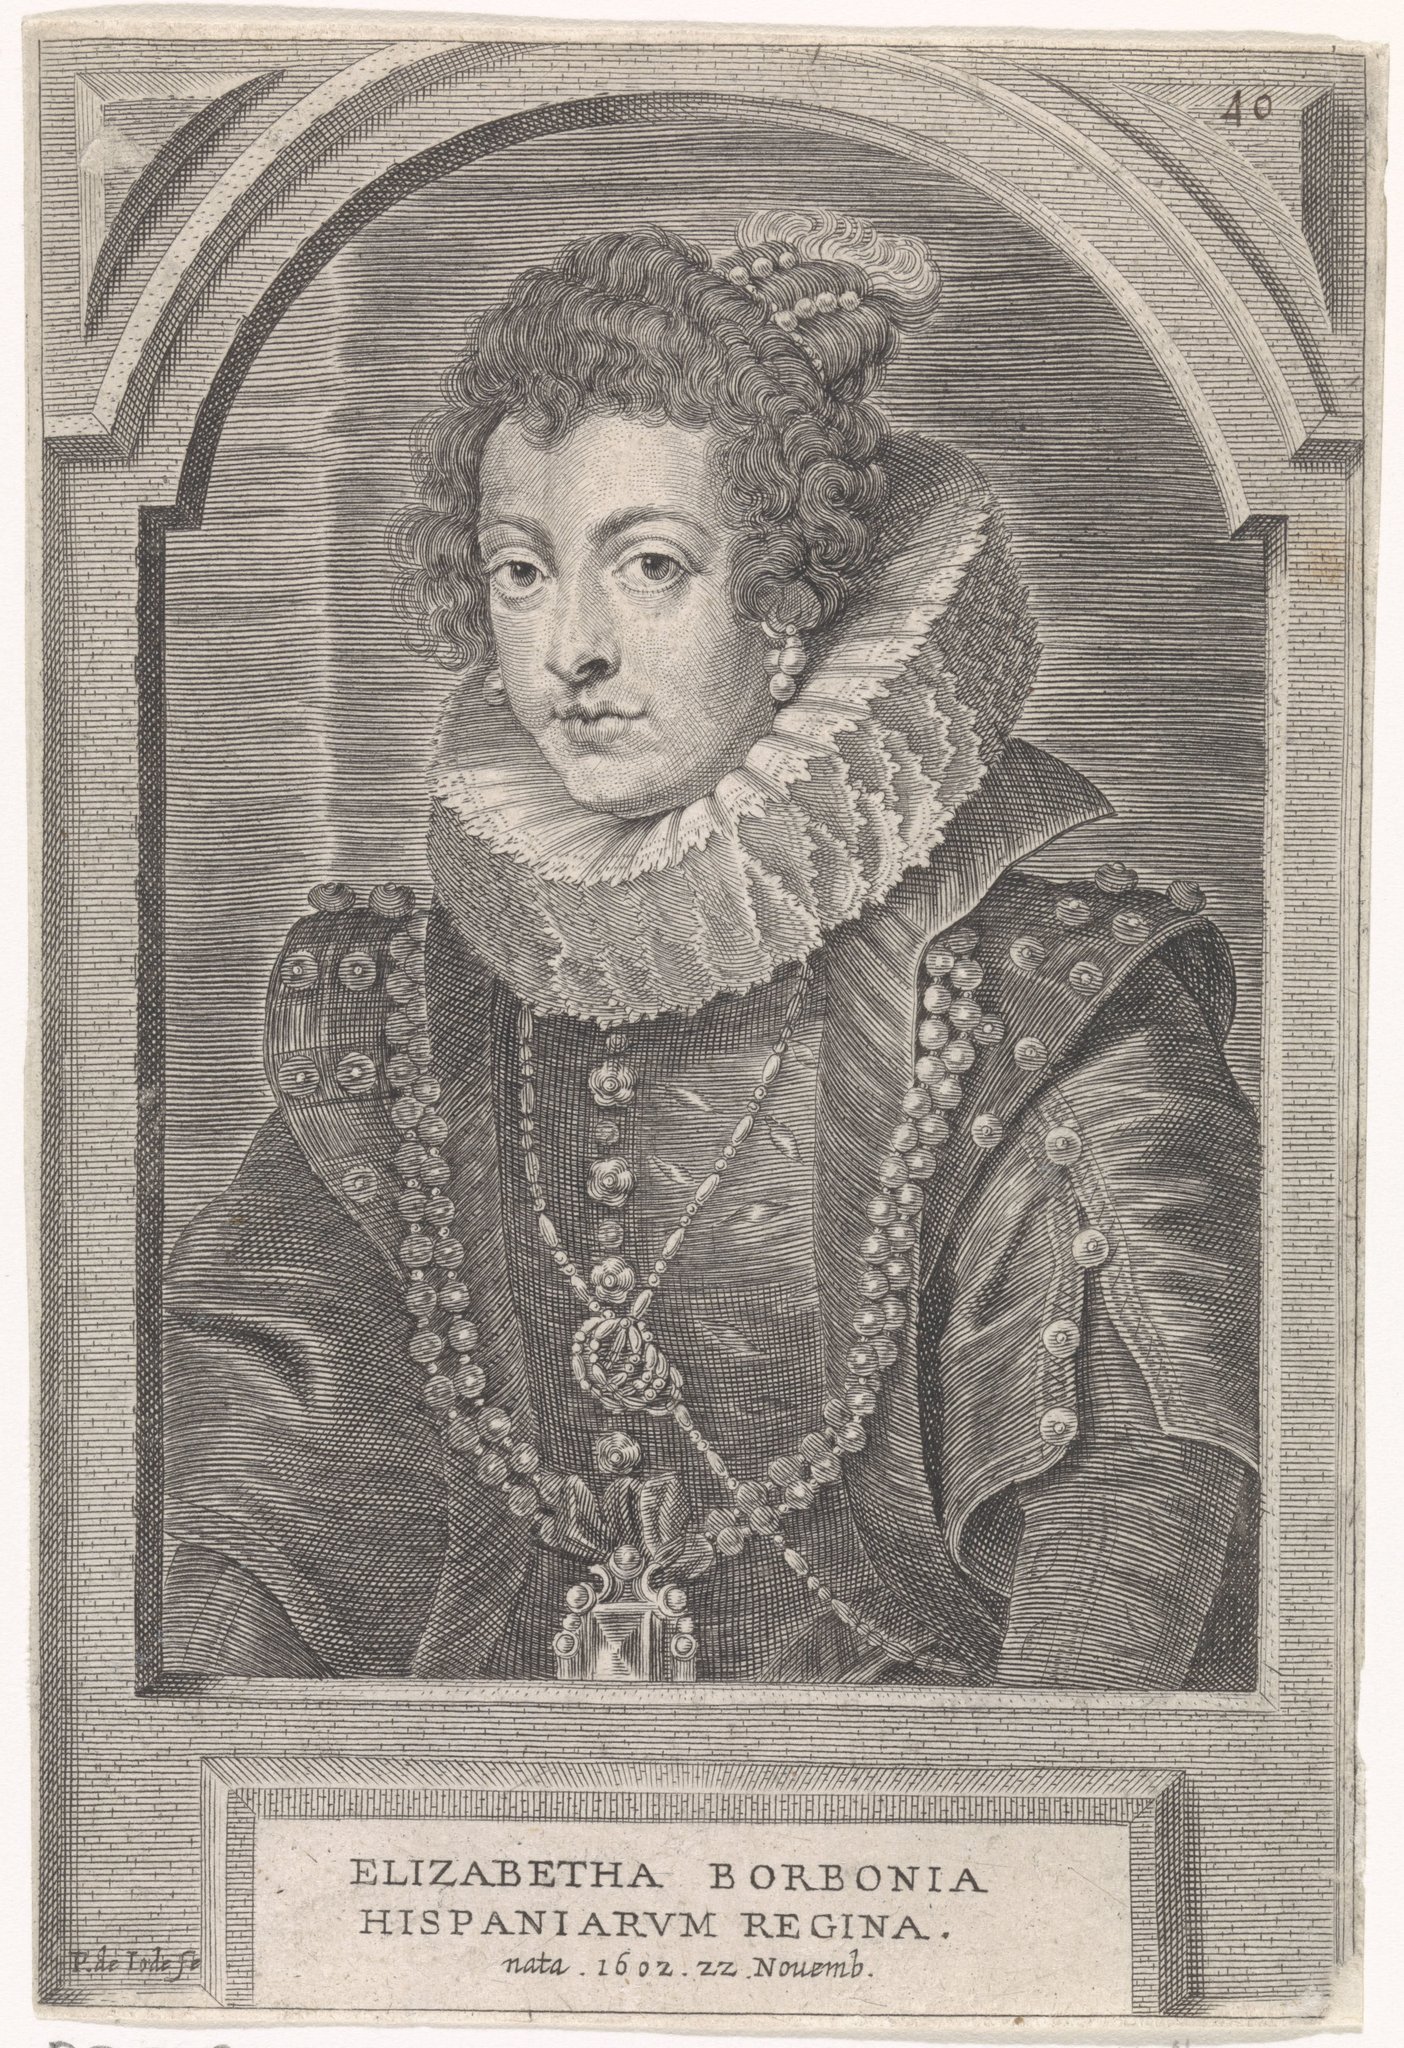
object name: print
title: Theater van bisschoppen, keizers, koningen, hertogen, prinsen, enz.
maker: pieter de jode (ii)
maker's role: draughtsman, print maker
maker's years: 1606-1674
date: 1628-1670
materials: paper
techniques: engraving, etching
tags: elisabeth of france (queen of spain and portugal)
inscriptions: collector's mark: Lugt 2228, inscription: ‘40’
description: Busteportret van Elisabeth van Bourbon, in rijk versierde jurk. Het portret is gevat in een boogvormige omlijsting. In een kader een onderschrift in het Latijn.